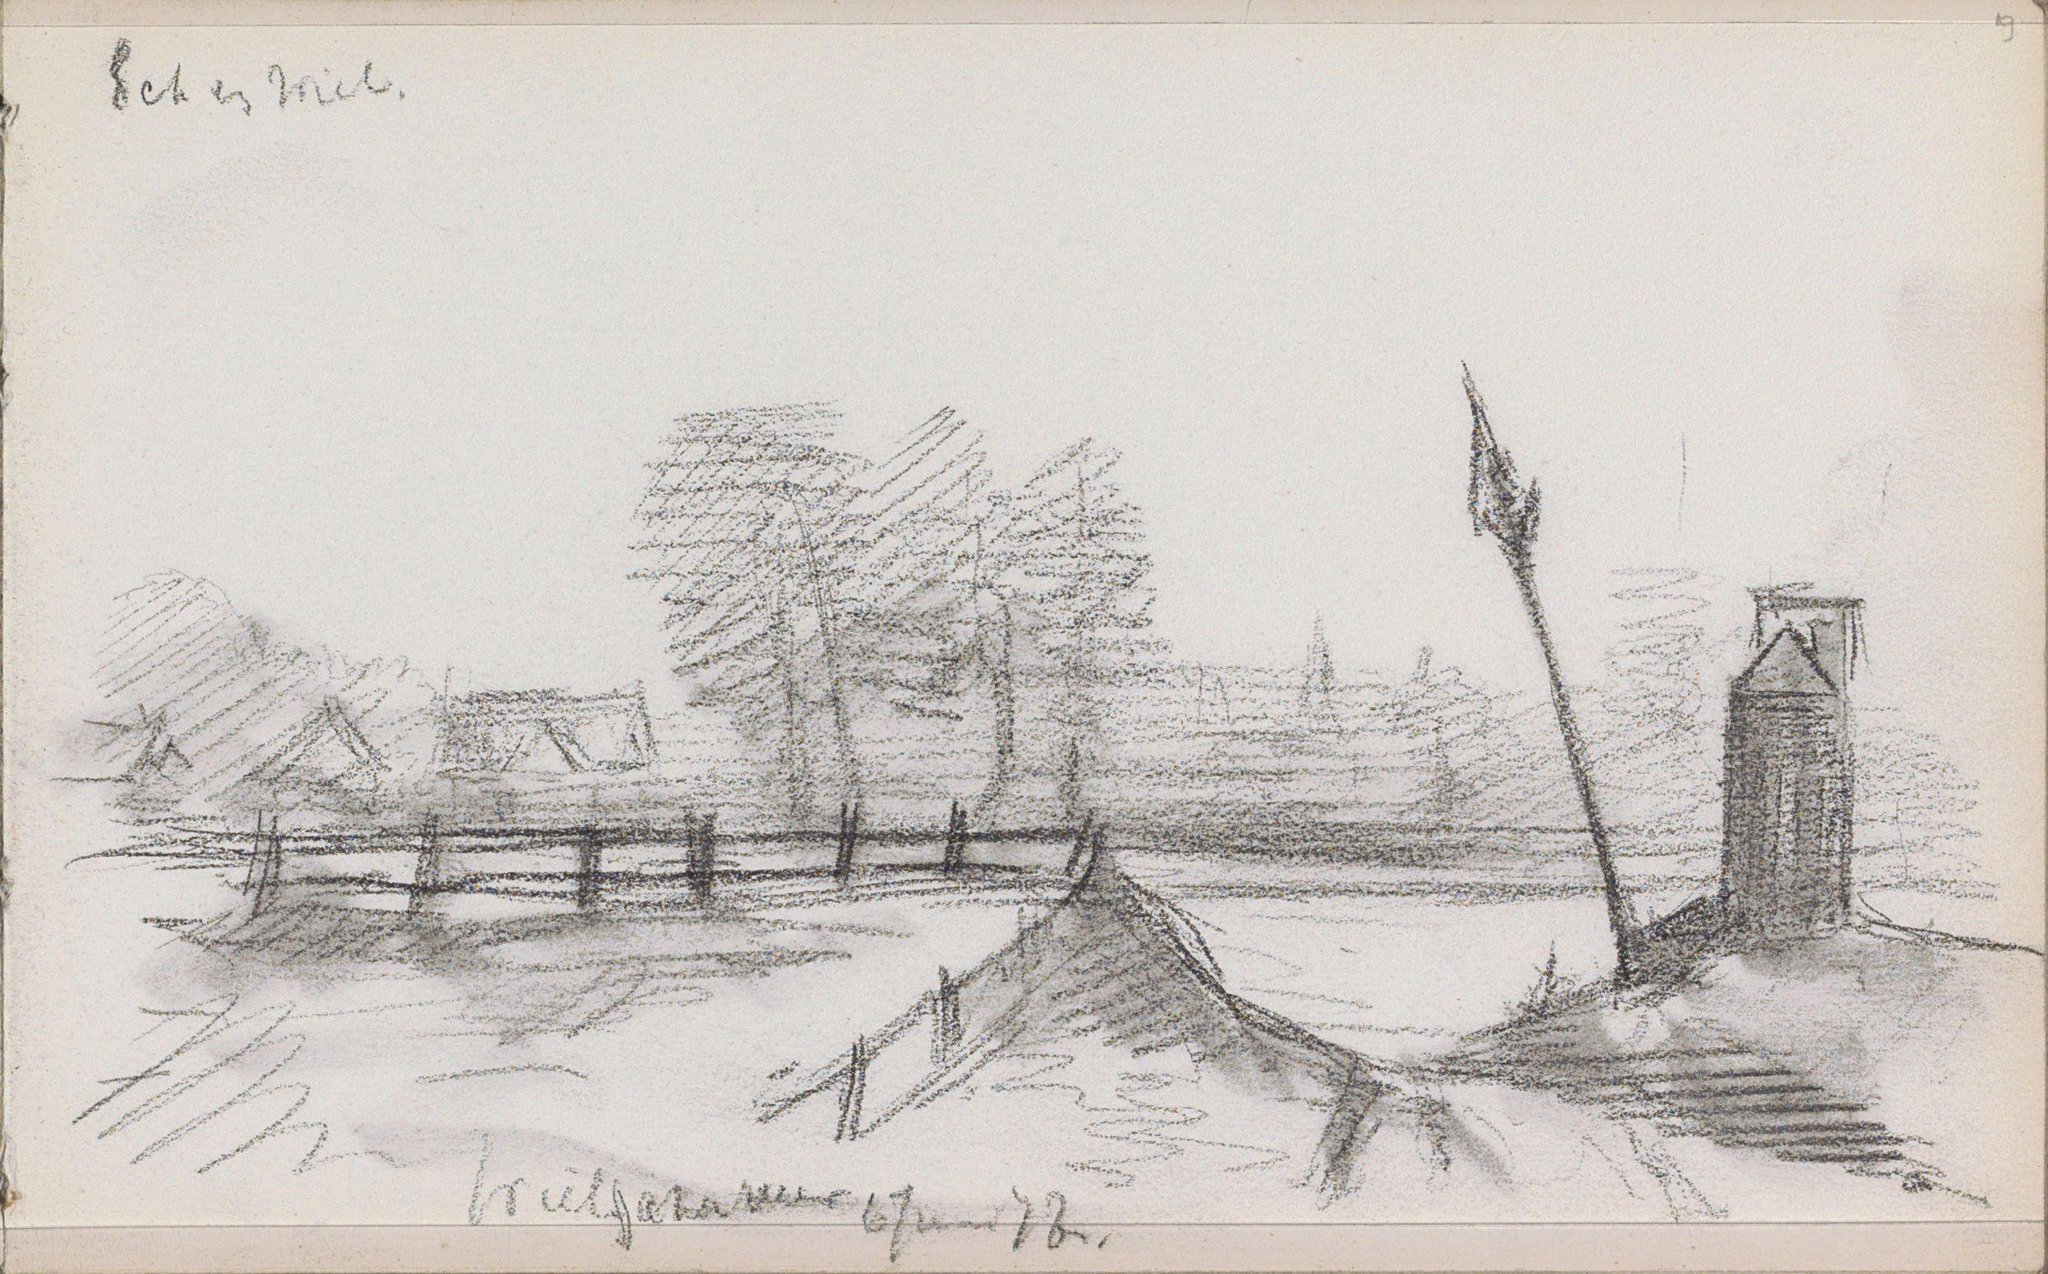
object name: sketchbook leaf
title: Gezicht op het Wielseveer bij Eck en Wiel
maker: willem witsen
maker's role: draughtsman, painter, print maker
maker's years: 1860-1923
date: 1878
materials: chalk, paper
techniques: stumping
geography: eck en wiel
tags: landscapes with waters, waterscapes, seascapes (in the temperate zone), rural housing, e.g. country-house, villa, cottage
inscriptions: annotation: ‘Eck en Wiel./ Wielscheveer’, date: ‘6 Juni 78.’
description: Pagina 19 uit een schetsboek met 23 bladen.